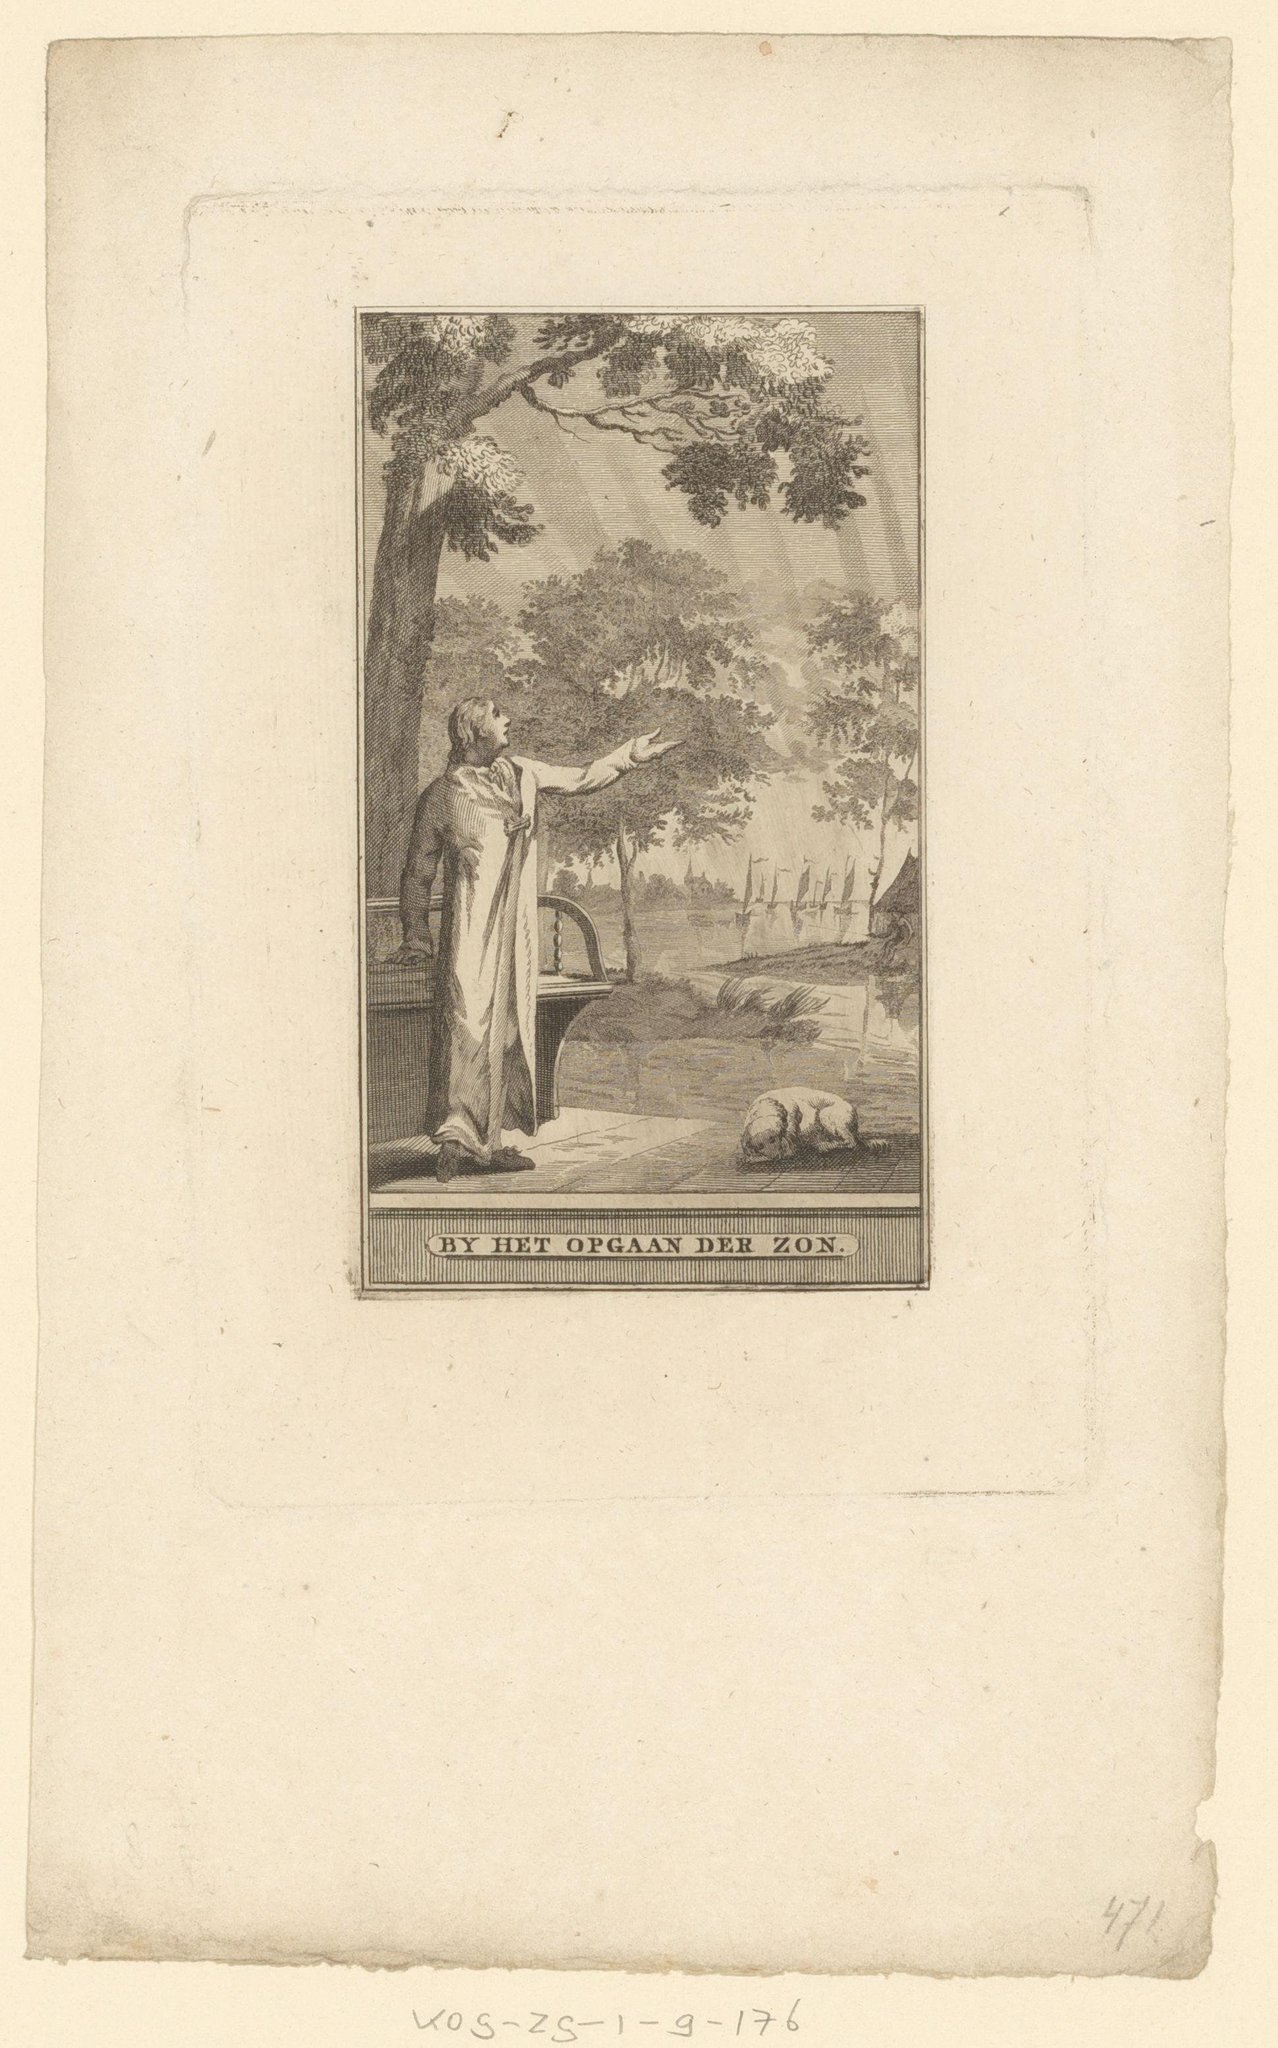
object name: print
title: Staande man kijkt naar de opkomende zon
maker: Anonymous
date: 1822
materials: paper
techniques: etching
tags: standing figure, sailing-ship, sailing-boat, sunrise, dog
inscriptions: stamp, collector's mark: Lugt 1641, stamp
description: Prent waarschijnlijk uit: Zedekundig prentgeschenk aan de jeugd. Edam en Hoorn: Rolff en Vermande, 1822.